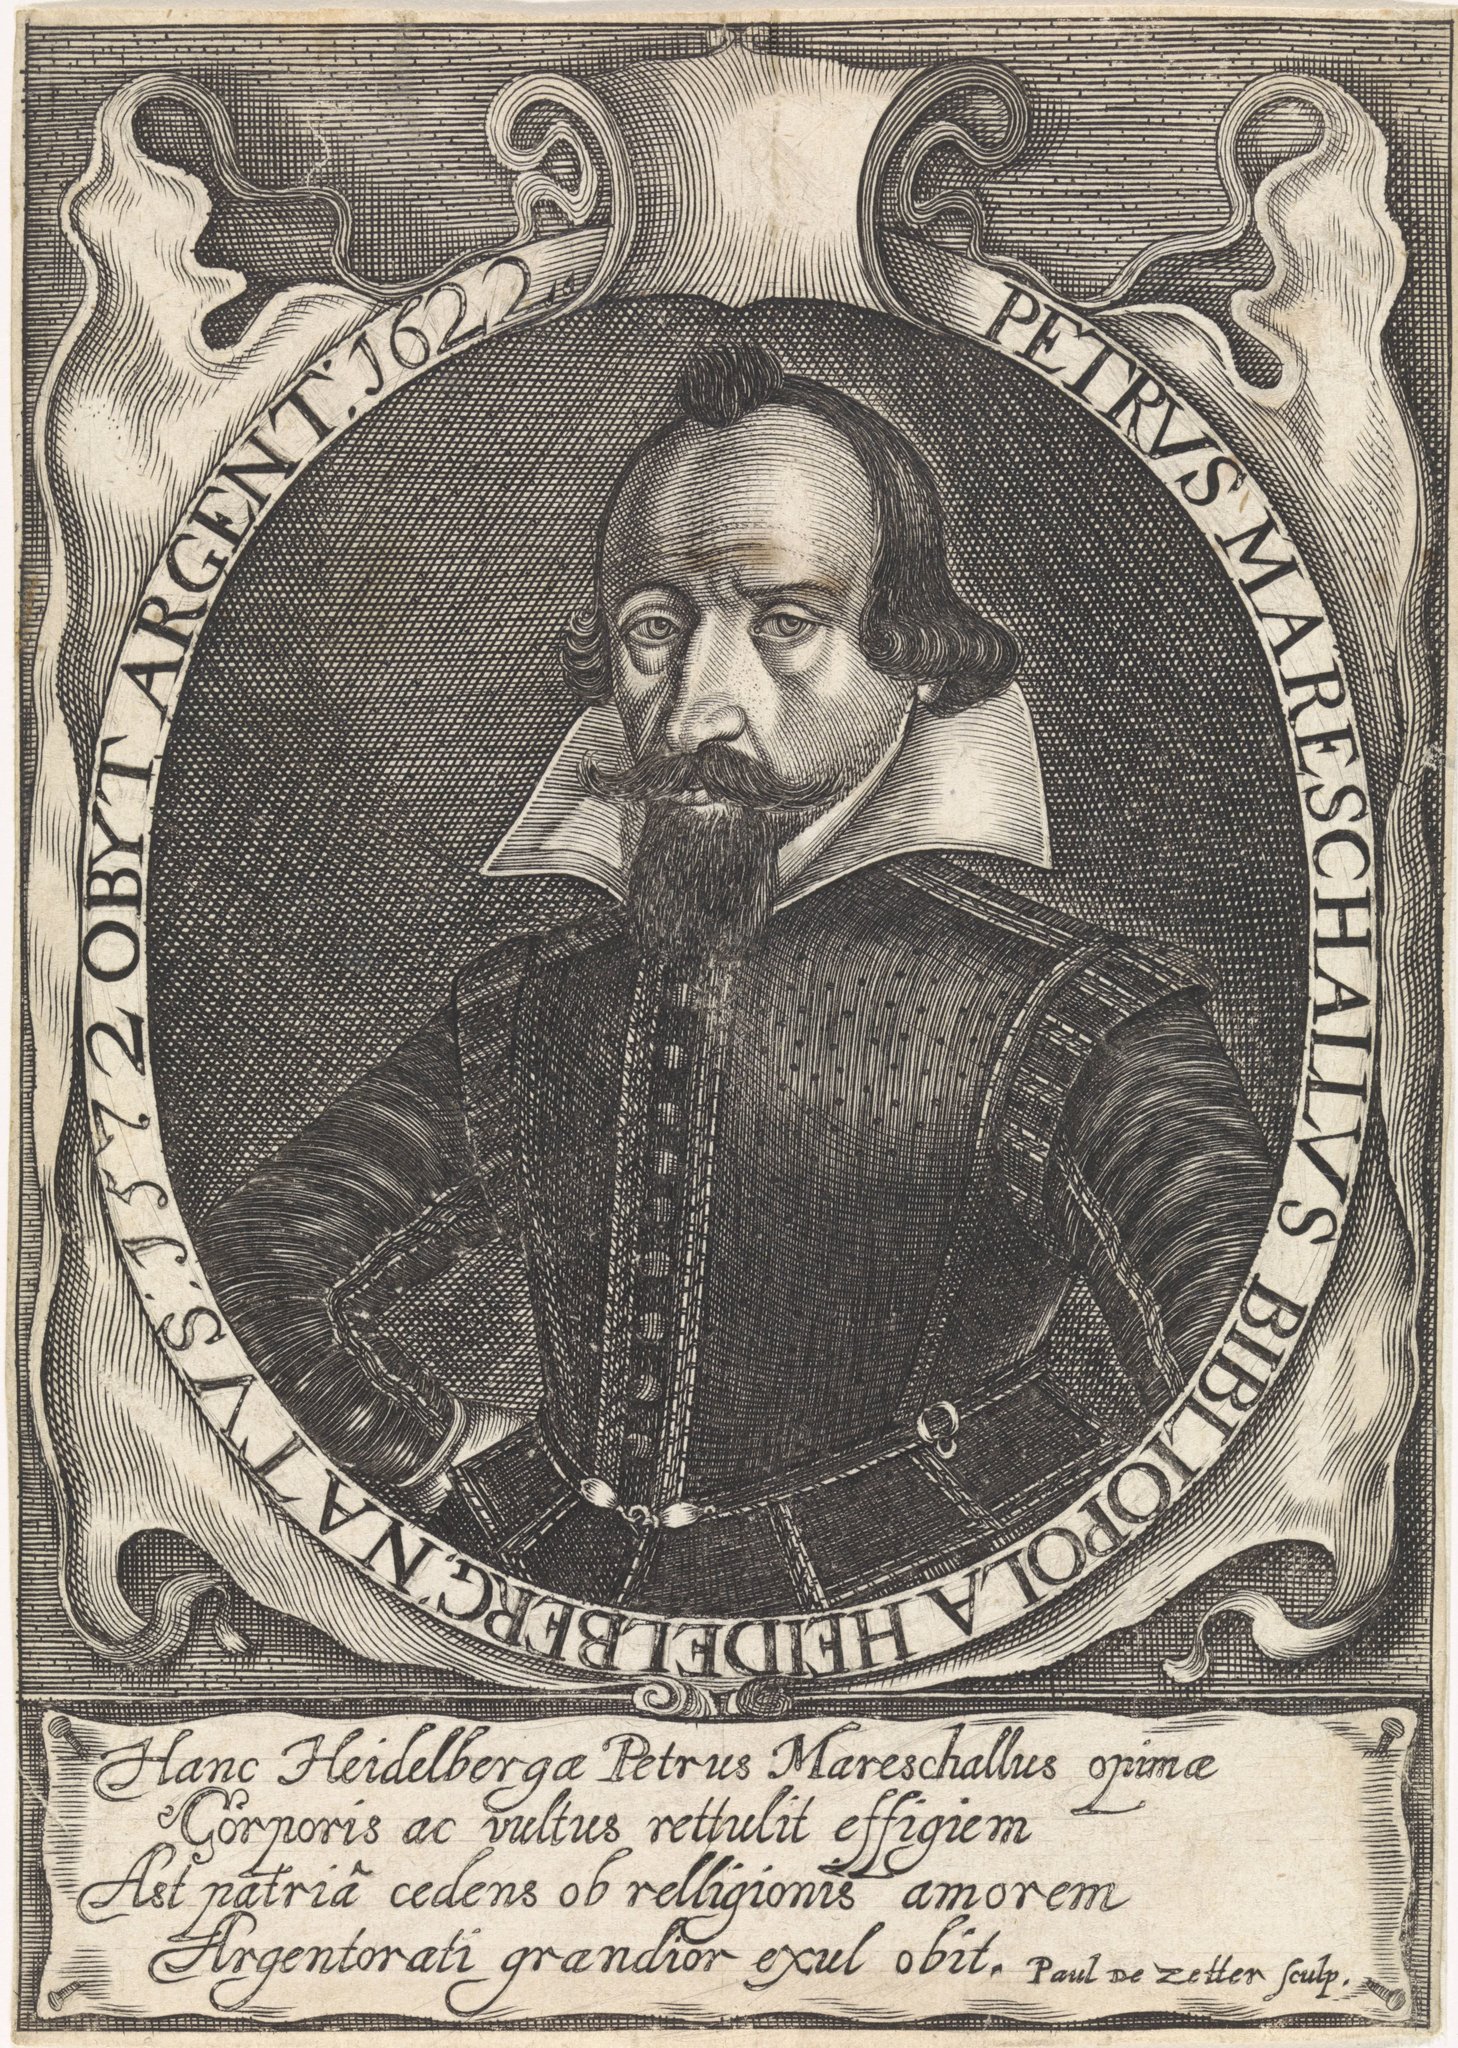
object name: print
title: Portret van Peter Marschall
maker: paul de zetter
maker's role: print maker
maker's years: 1600-1667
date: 1622-1624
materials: paper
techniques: engraving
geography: germany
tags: bookseller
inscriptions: collector's mark: Lugt 2228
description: Portret van Peter Marschall, boekverkoper in Heidelberg, in een ovale lijst met kwabornament.